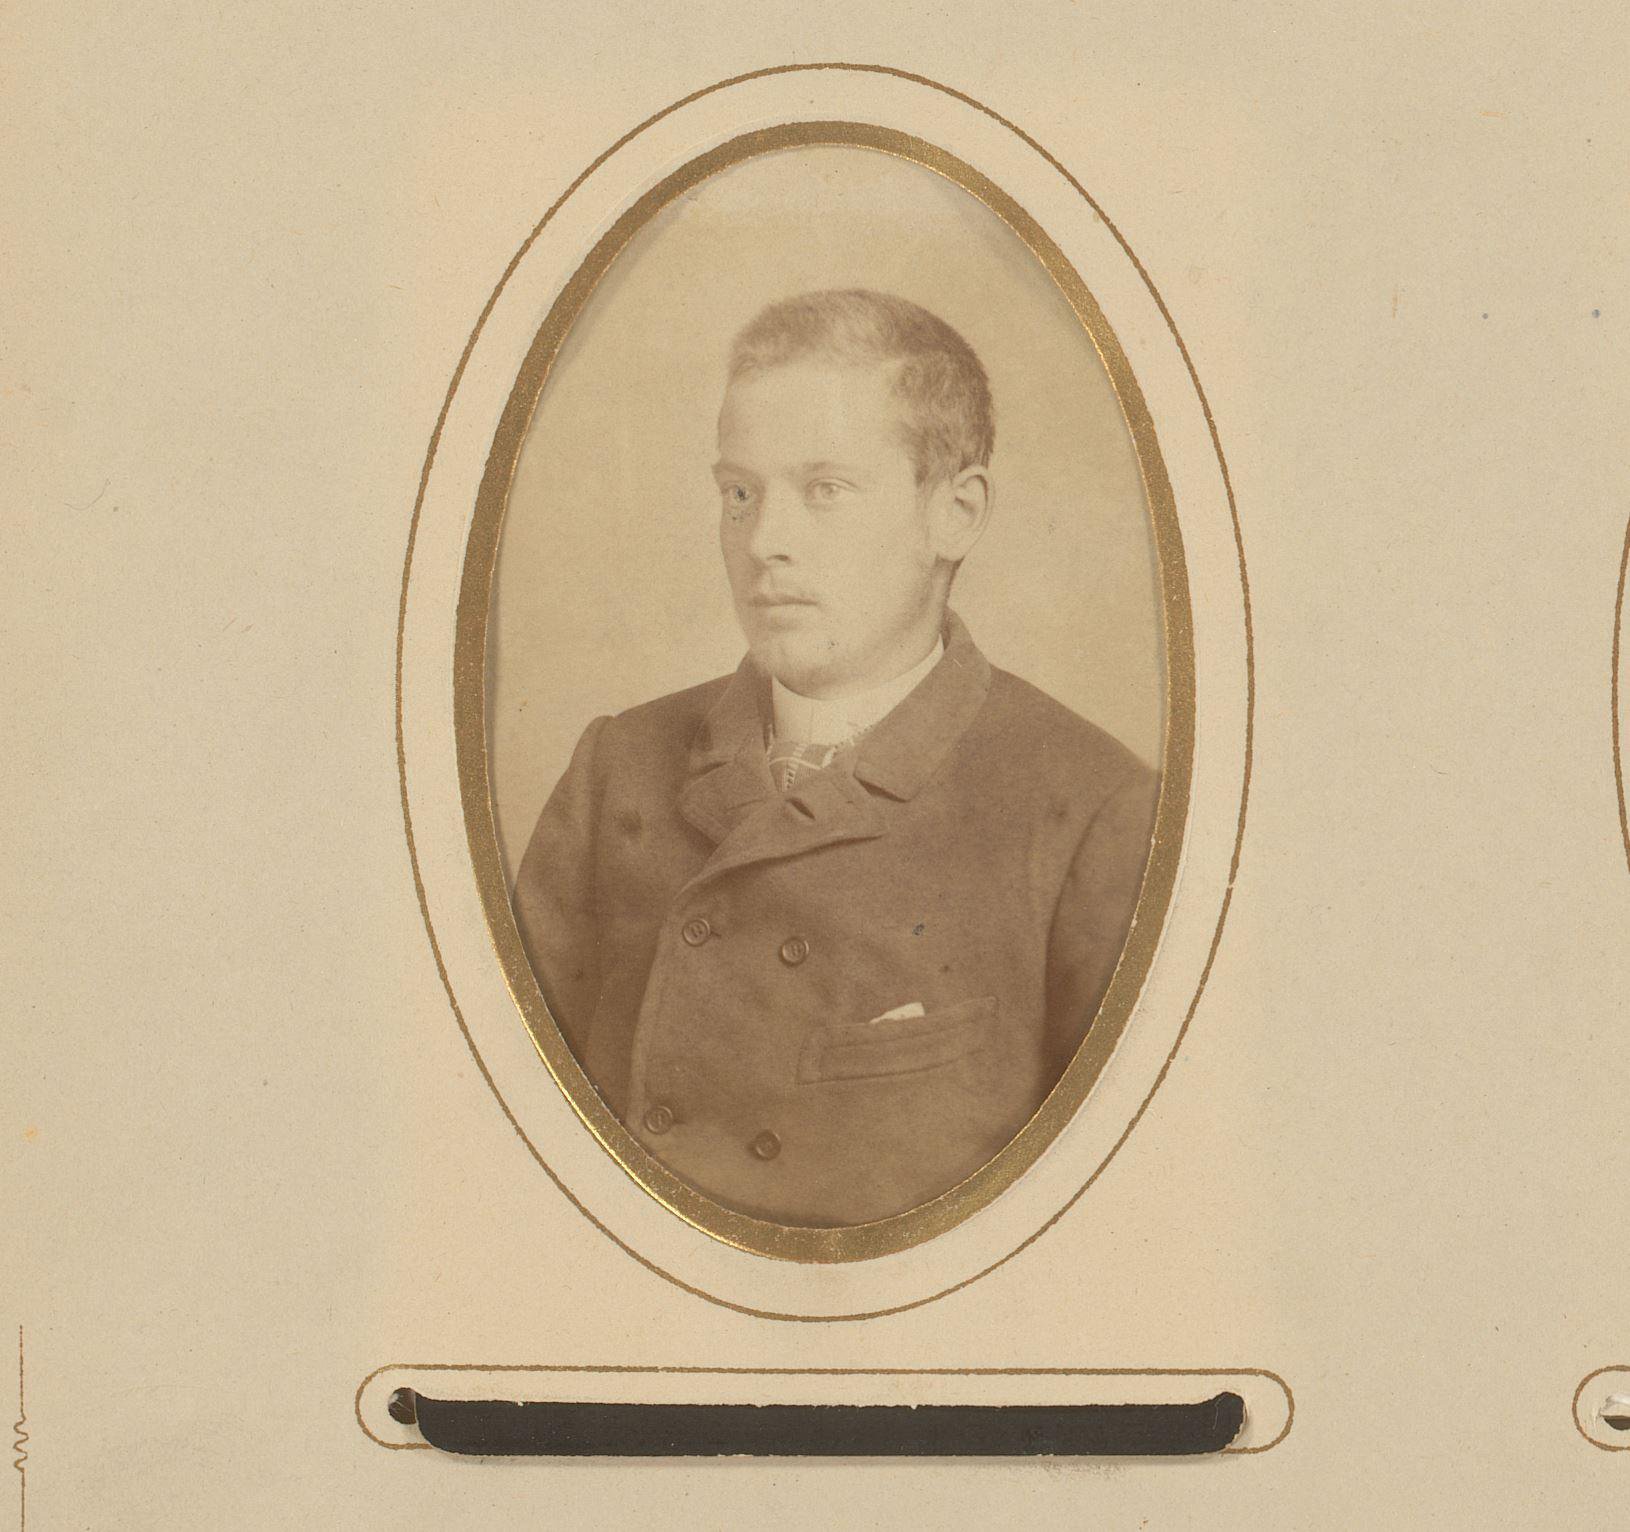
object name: photograph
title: Portret van een jonge man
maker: Anonymous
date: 1850-1900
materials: cardboard, photographic support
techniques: albumen print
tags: historical persons, youth, adolescent